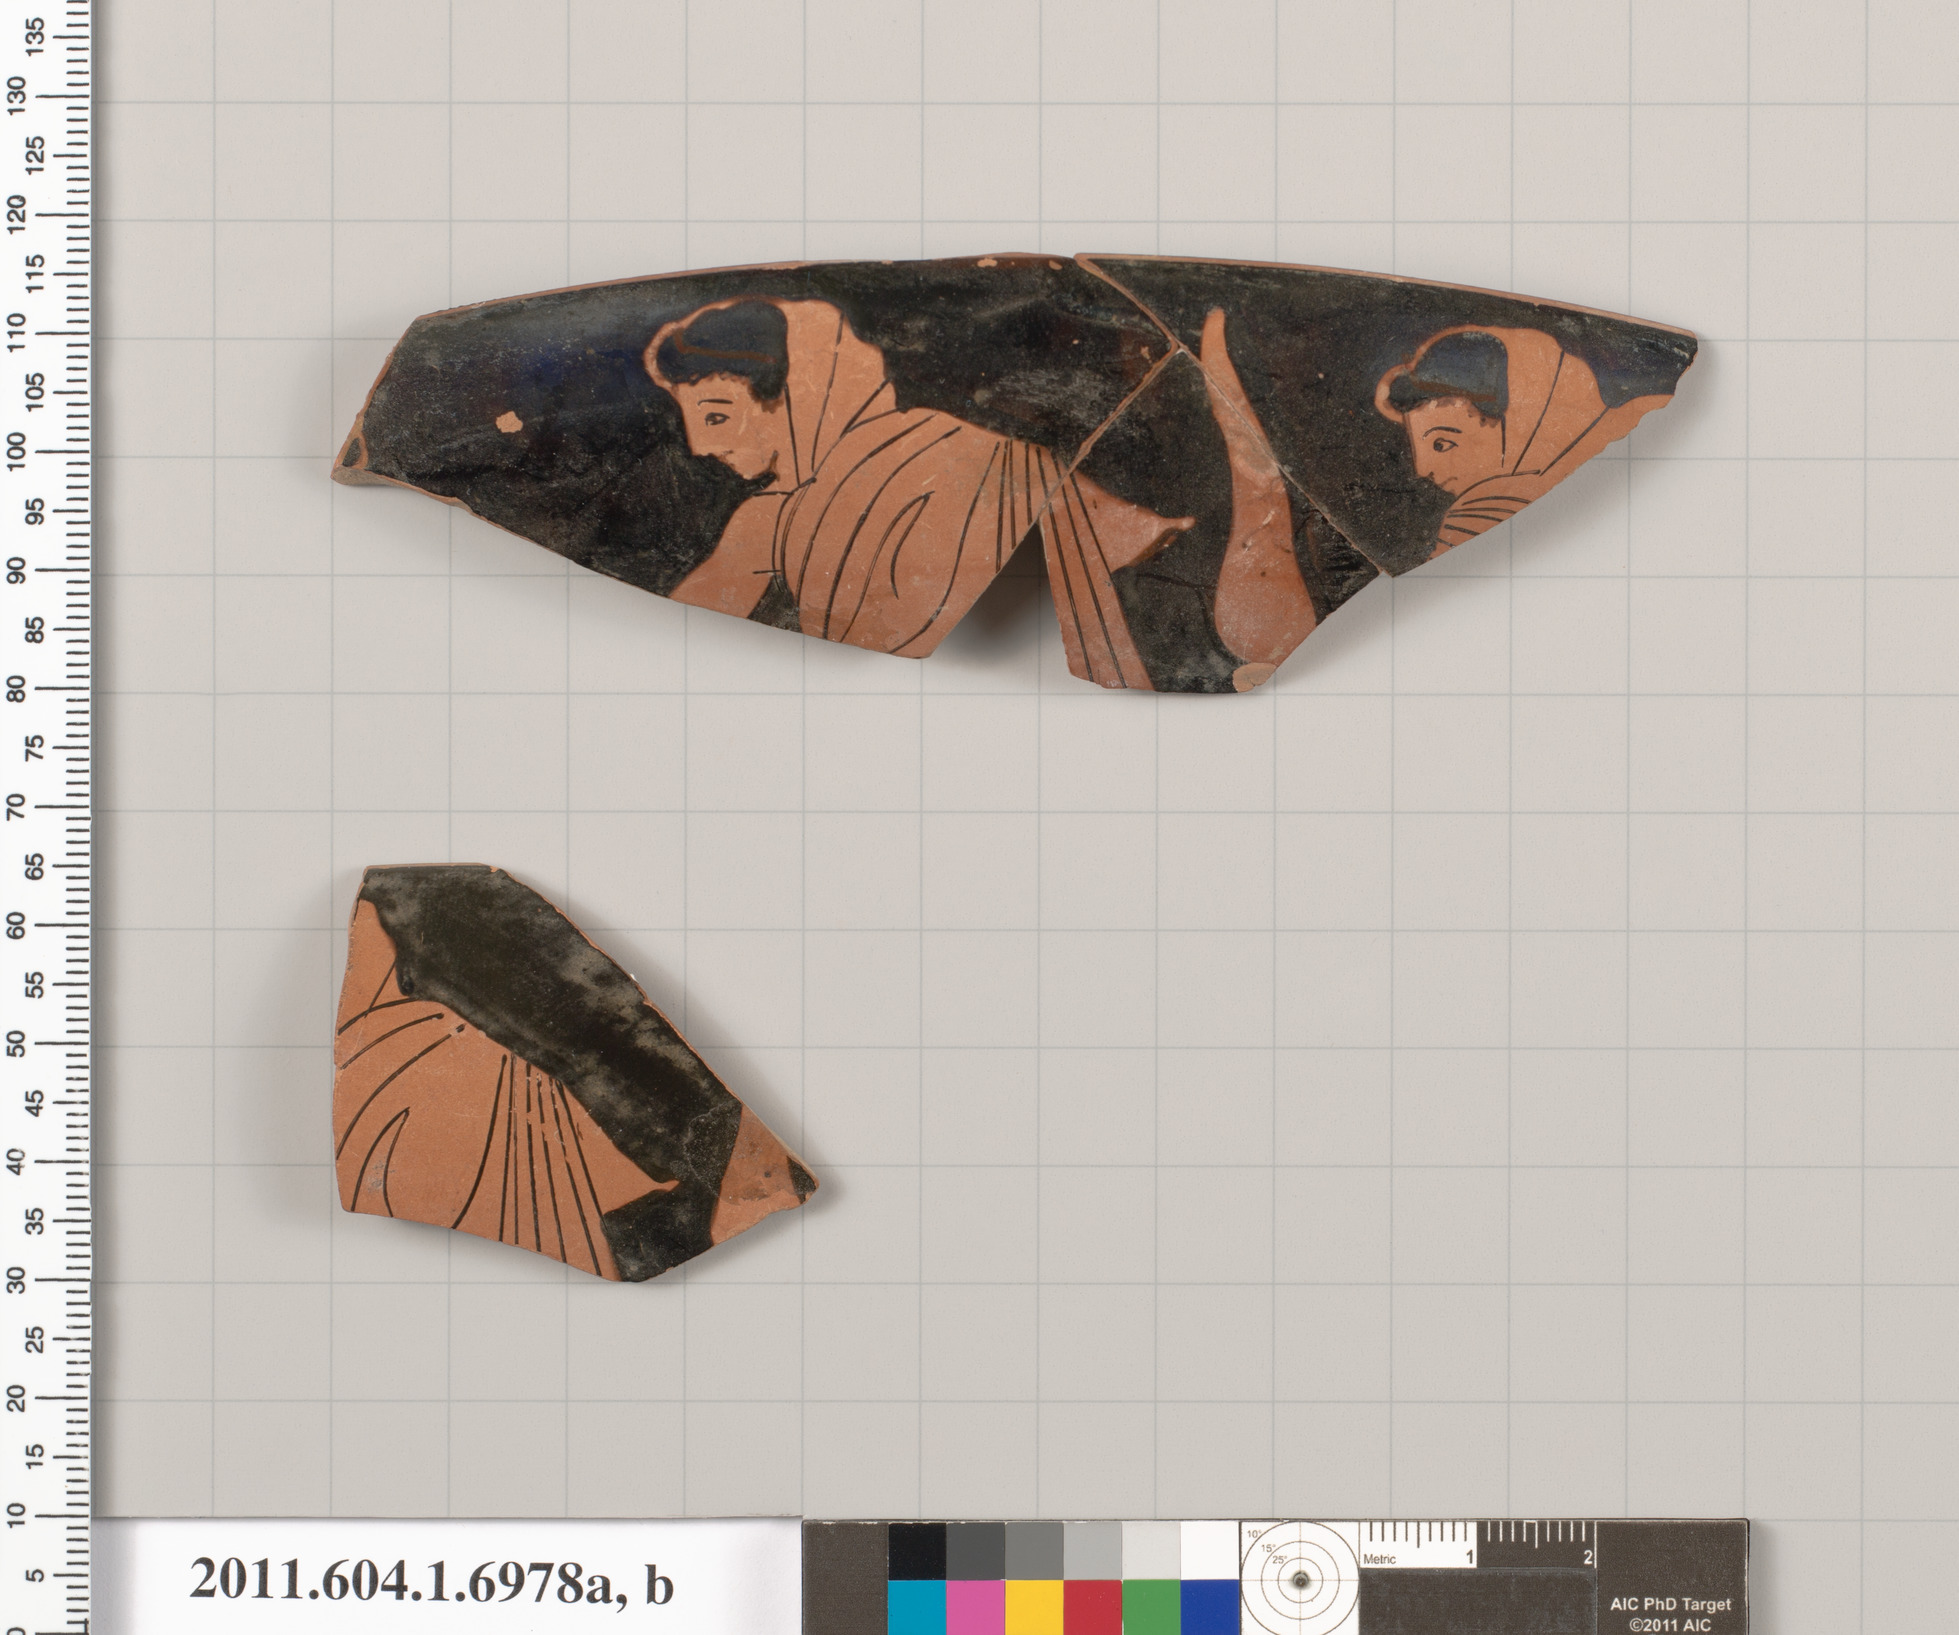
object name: kylix fragment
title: Terracotta rim fragments of a kylix (drinking cup)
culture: greek, attic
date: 490-470 BCE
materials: terracotta